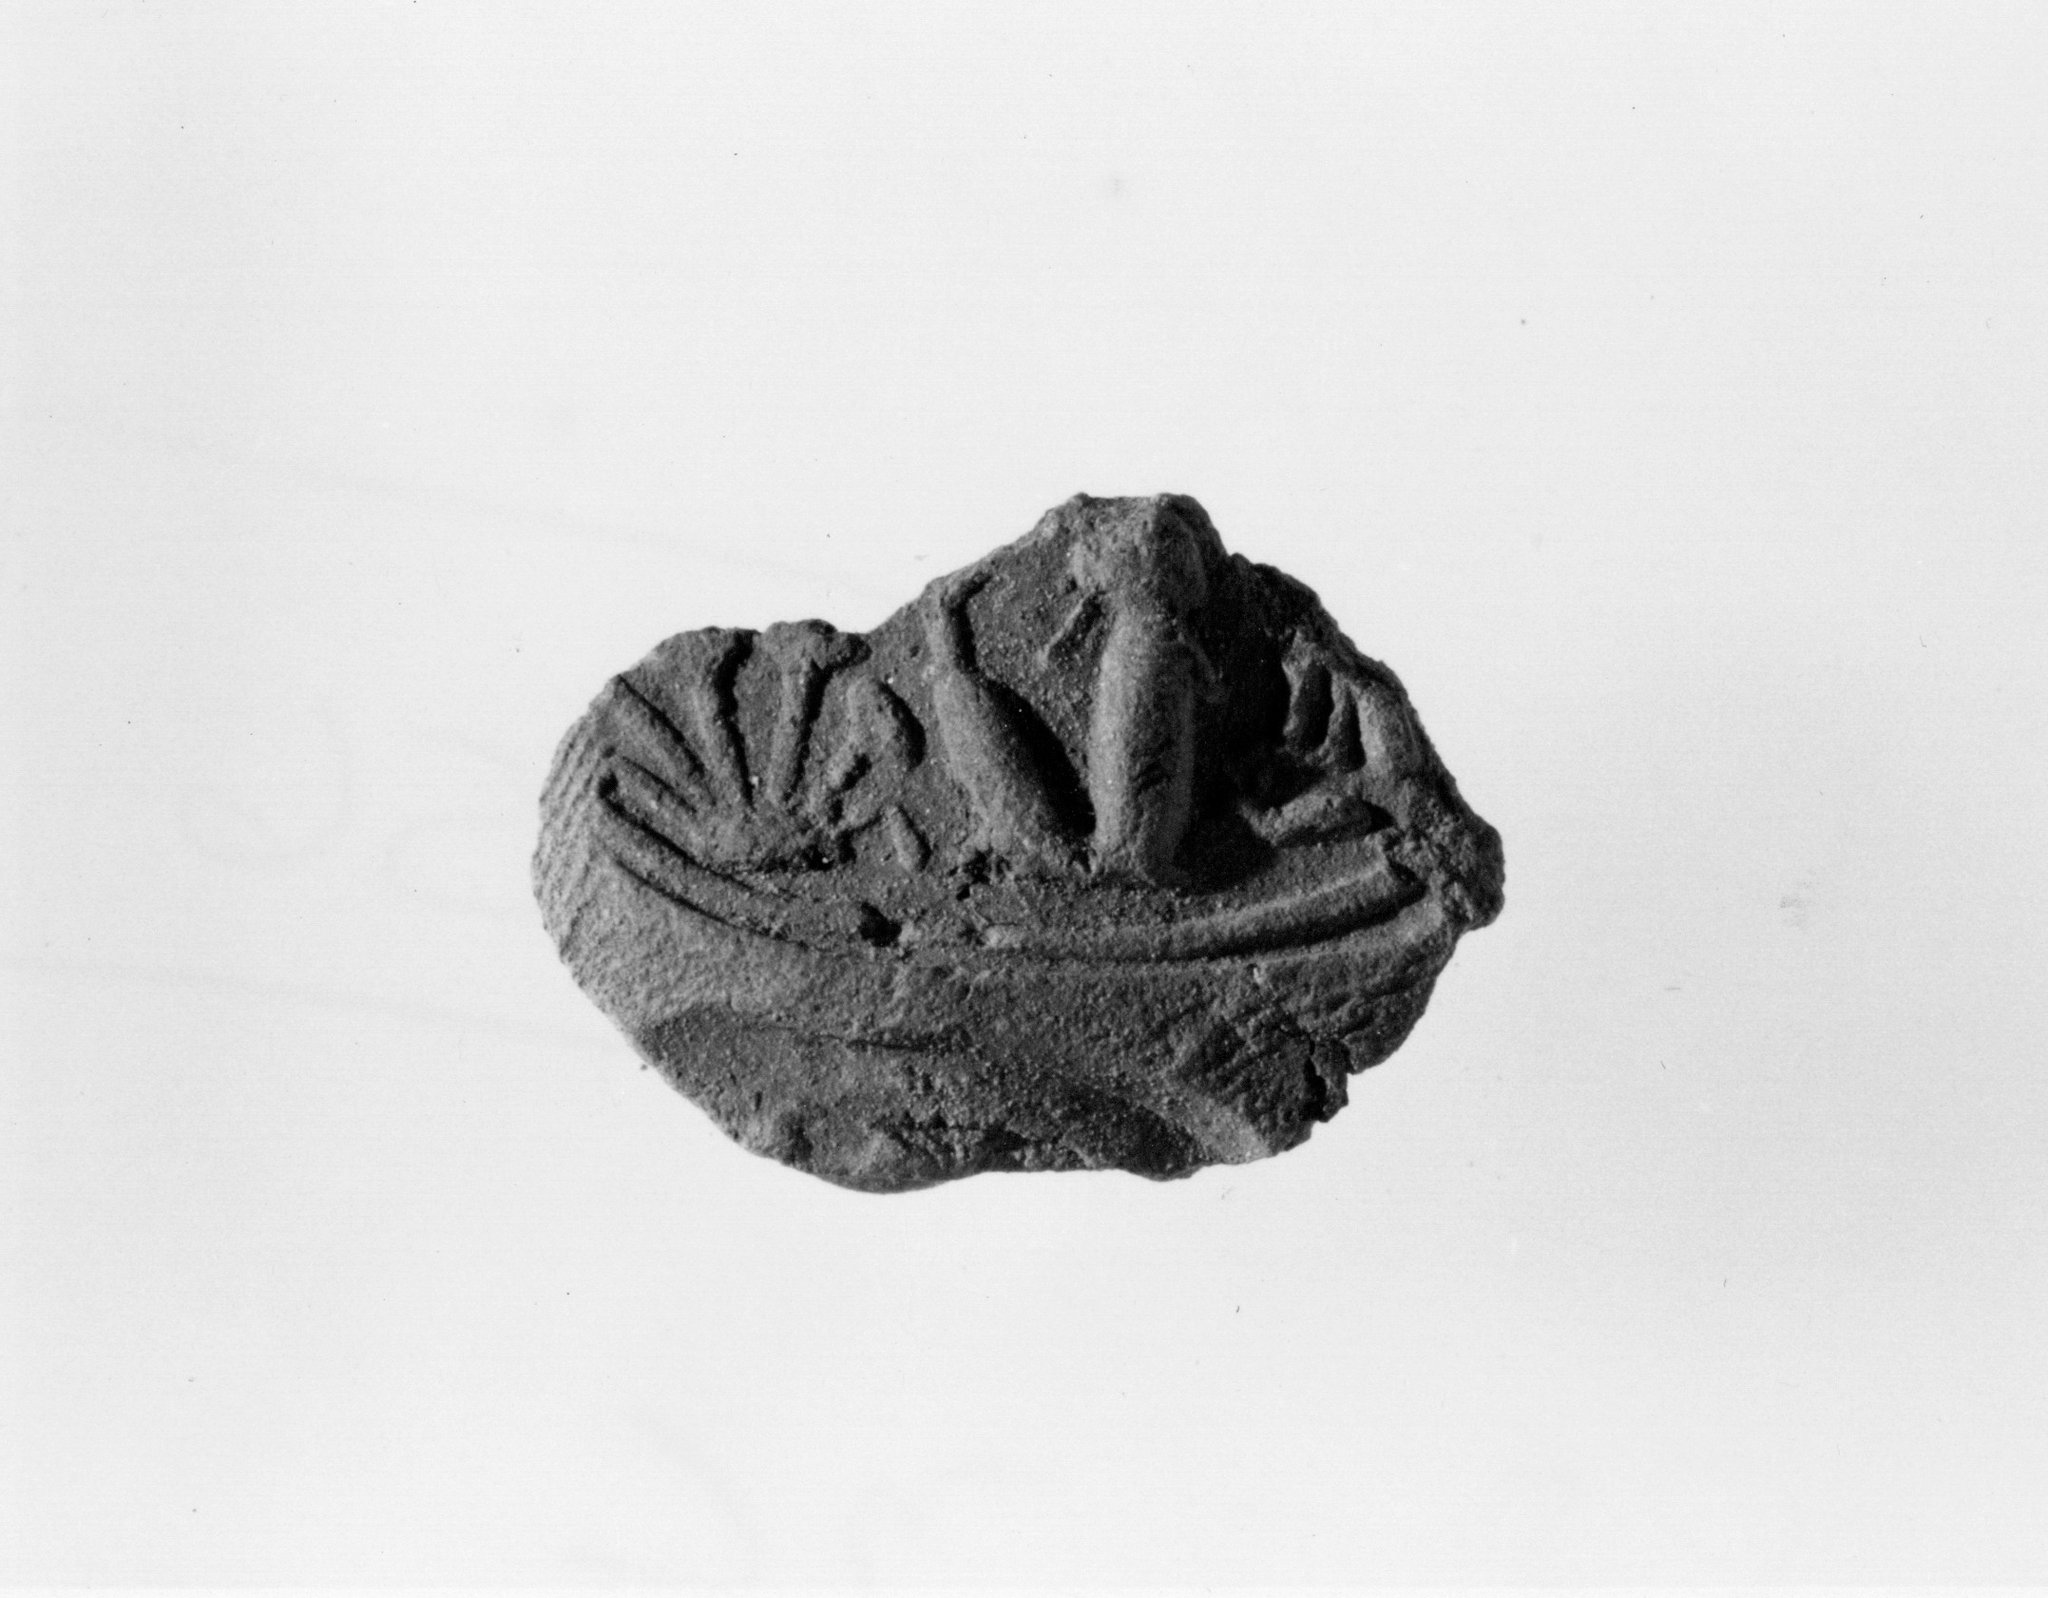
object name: sealing, nebmaatre, amenhotep iii, lower egypt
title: Document Sealing With the Throne Name of Amenhotep III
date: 1390-1352 BCE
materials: mud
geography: egypt